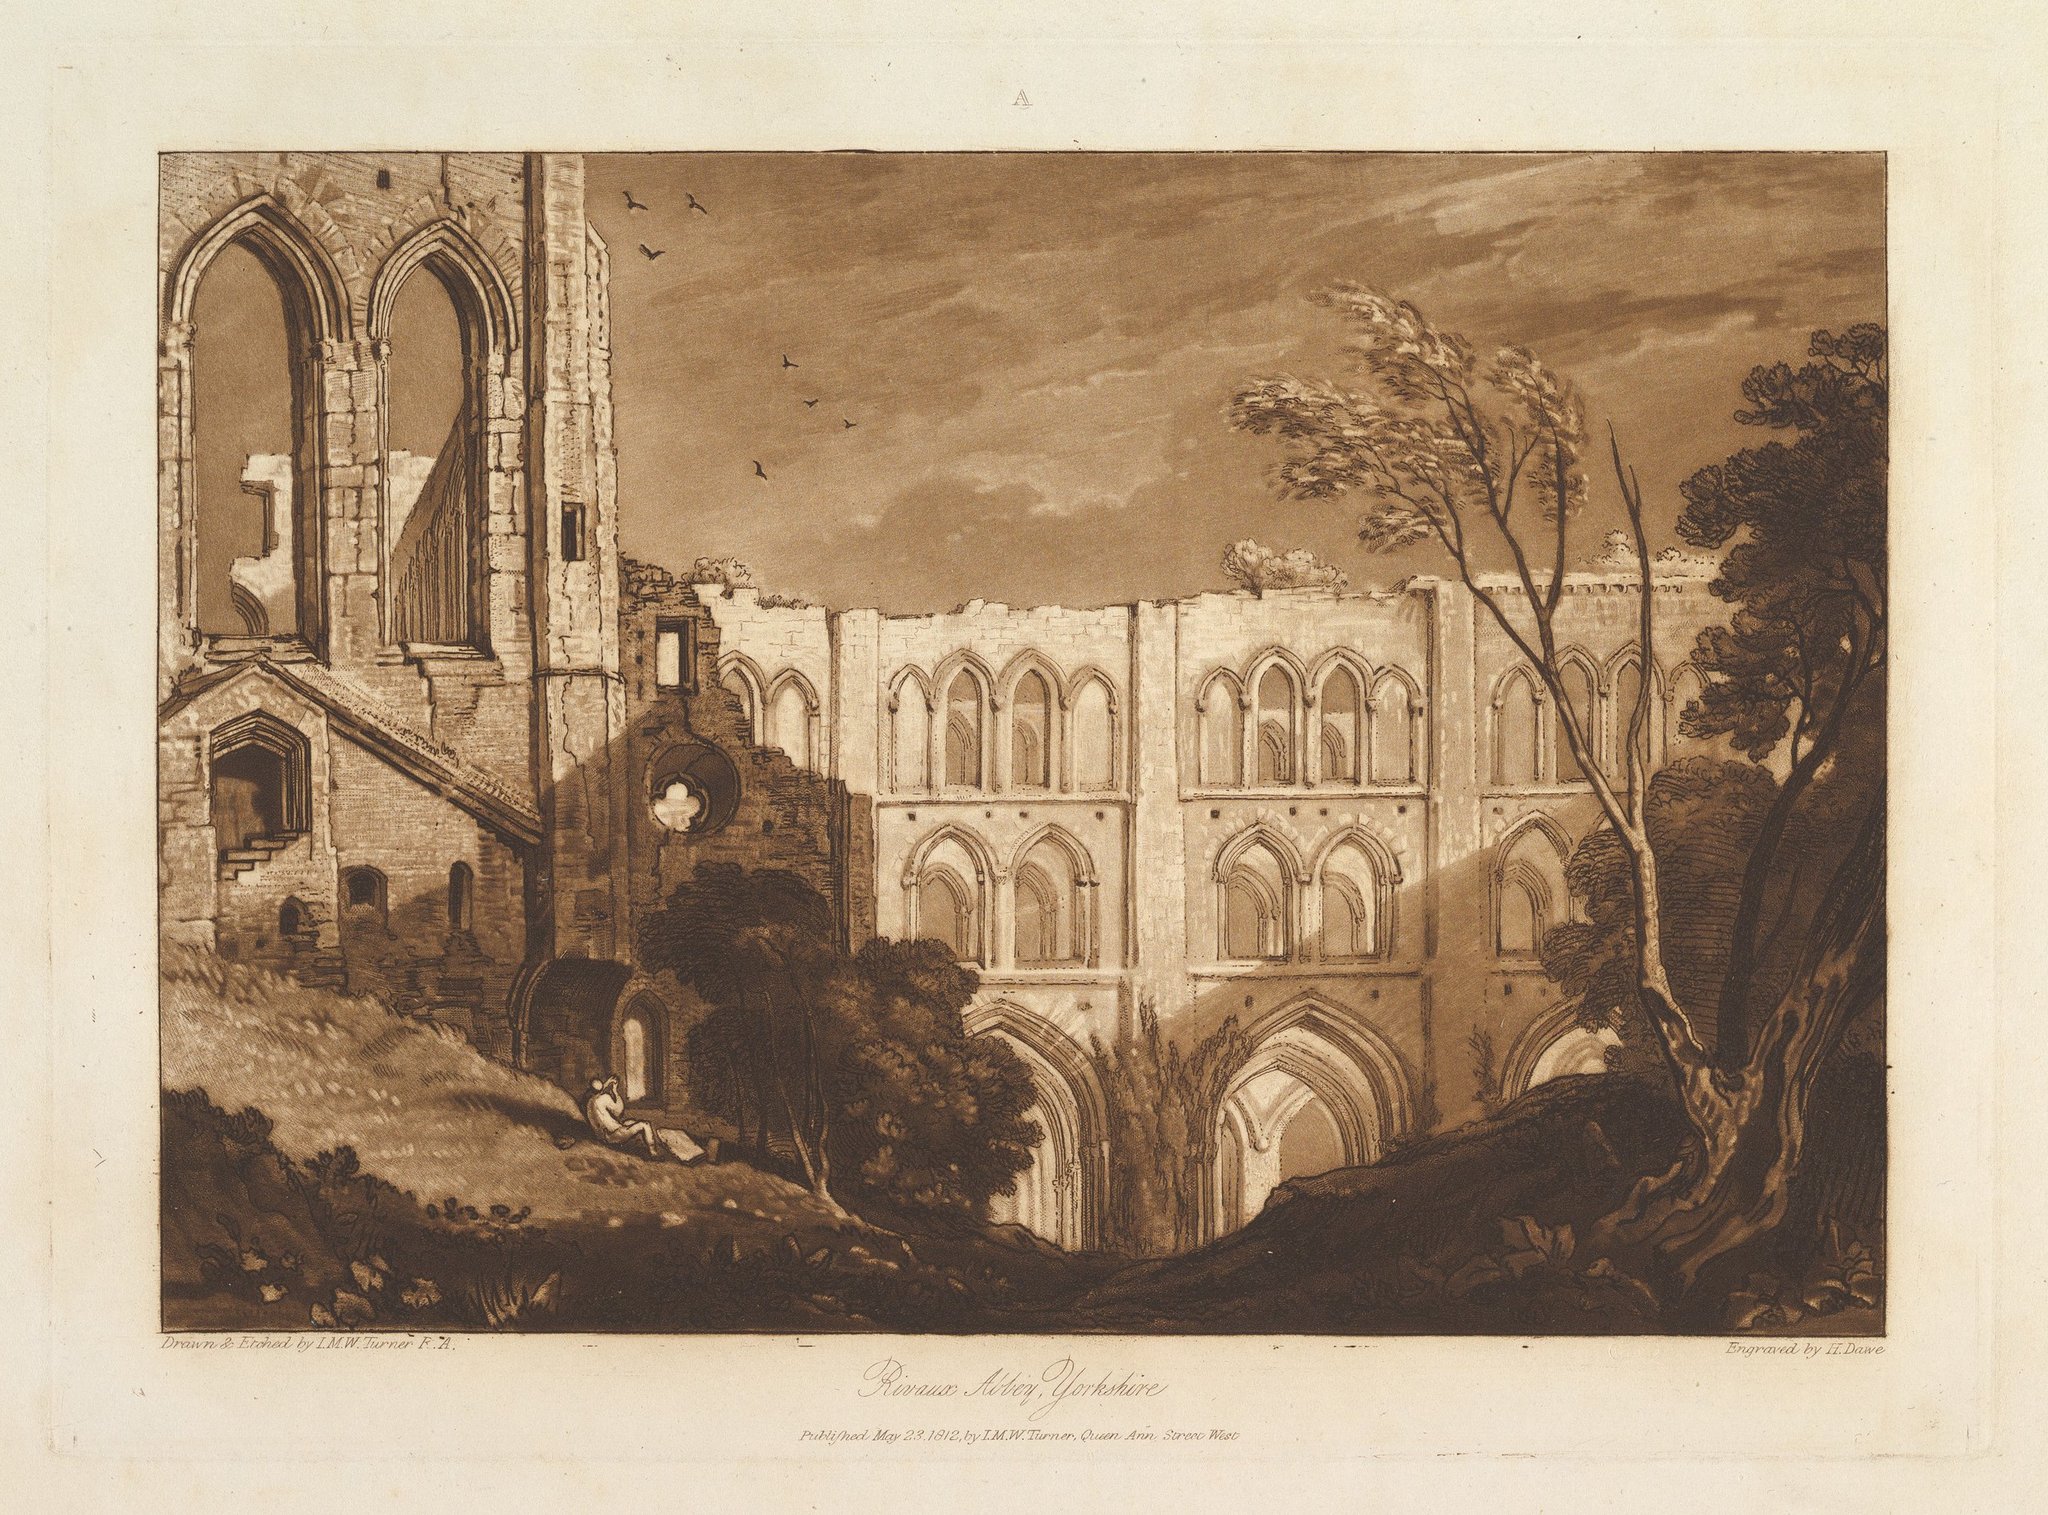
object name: print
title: Rivaux Abbey, Yorkshire, part X, plate 51 from "Liber Studiorum"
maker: joseph mallord william turner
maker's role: artist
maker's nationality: british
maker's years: 1775-1851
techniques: etching, mezzotint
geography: london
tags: abbeys,ruins